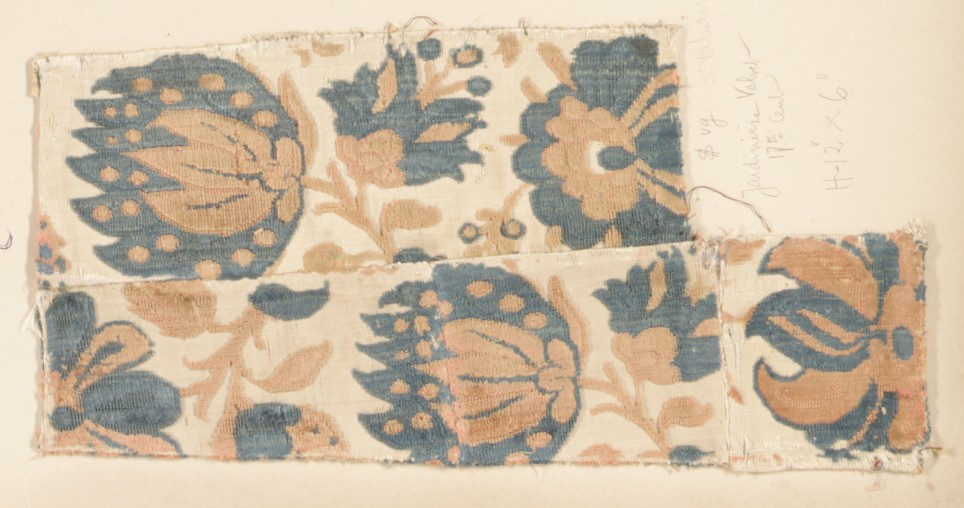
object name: fragment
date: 1601-1700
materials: silk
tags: flowers,leaves